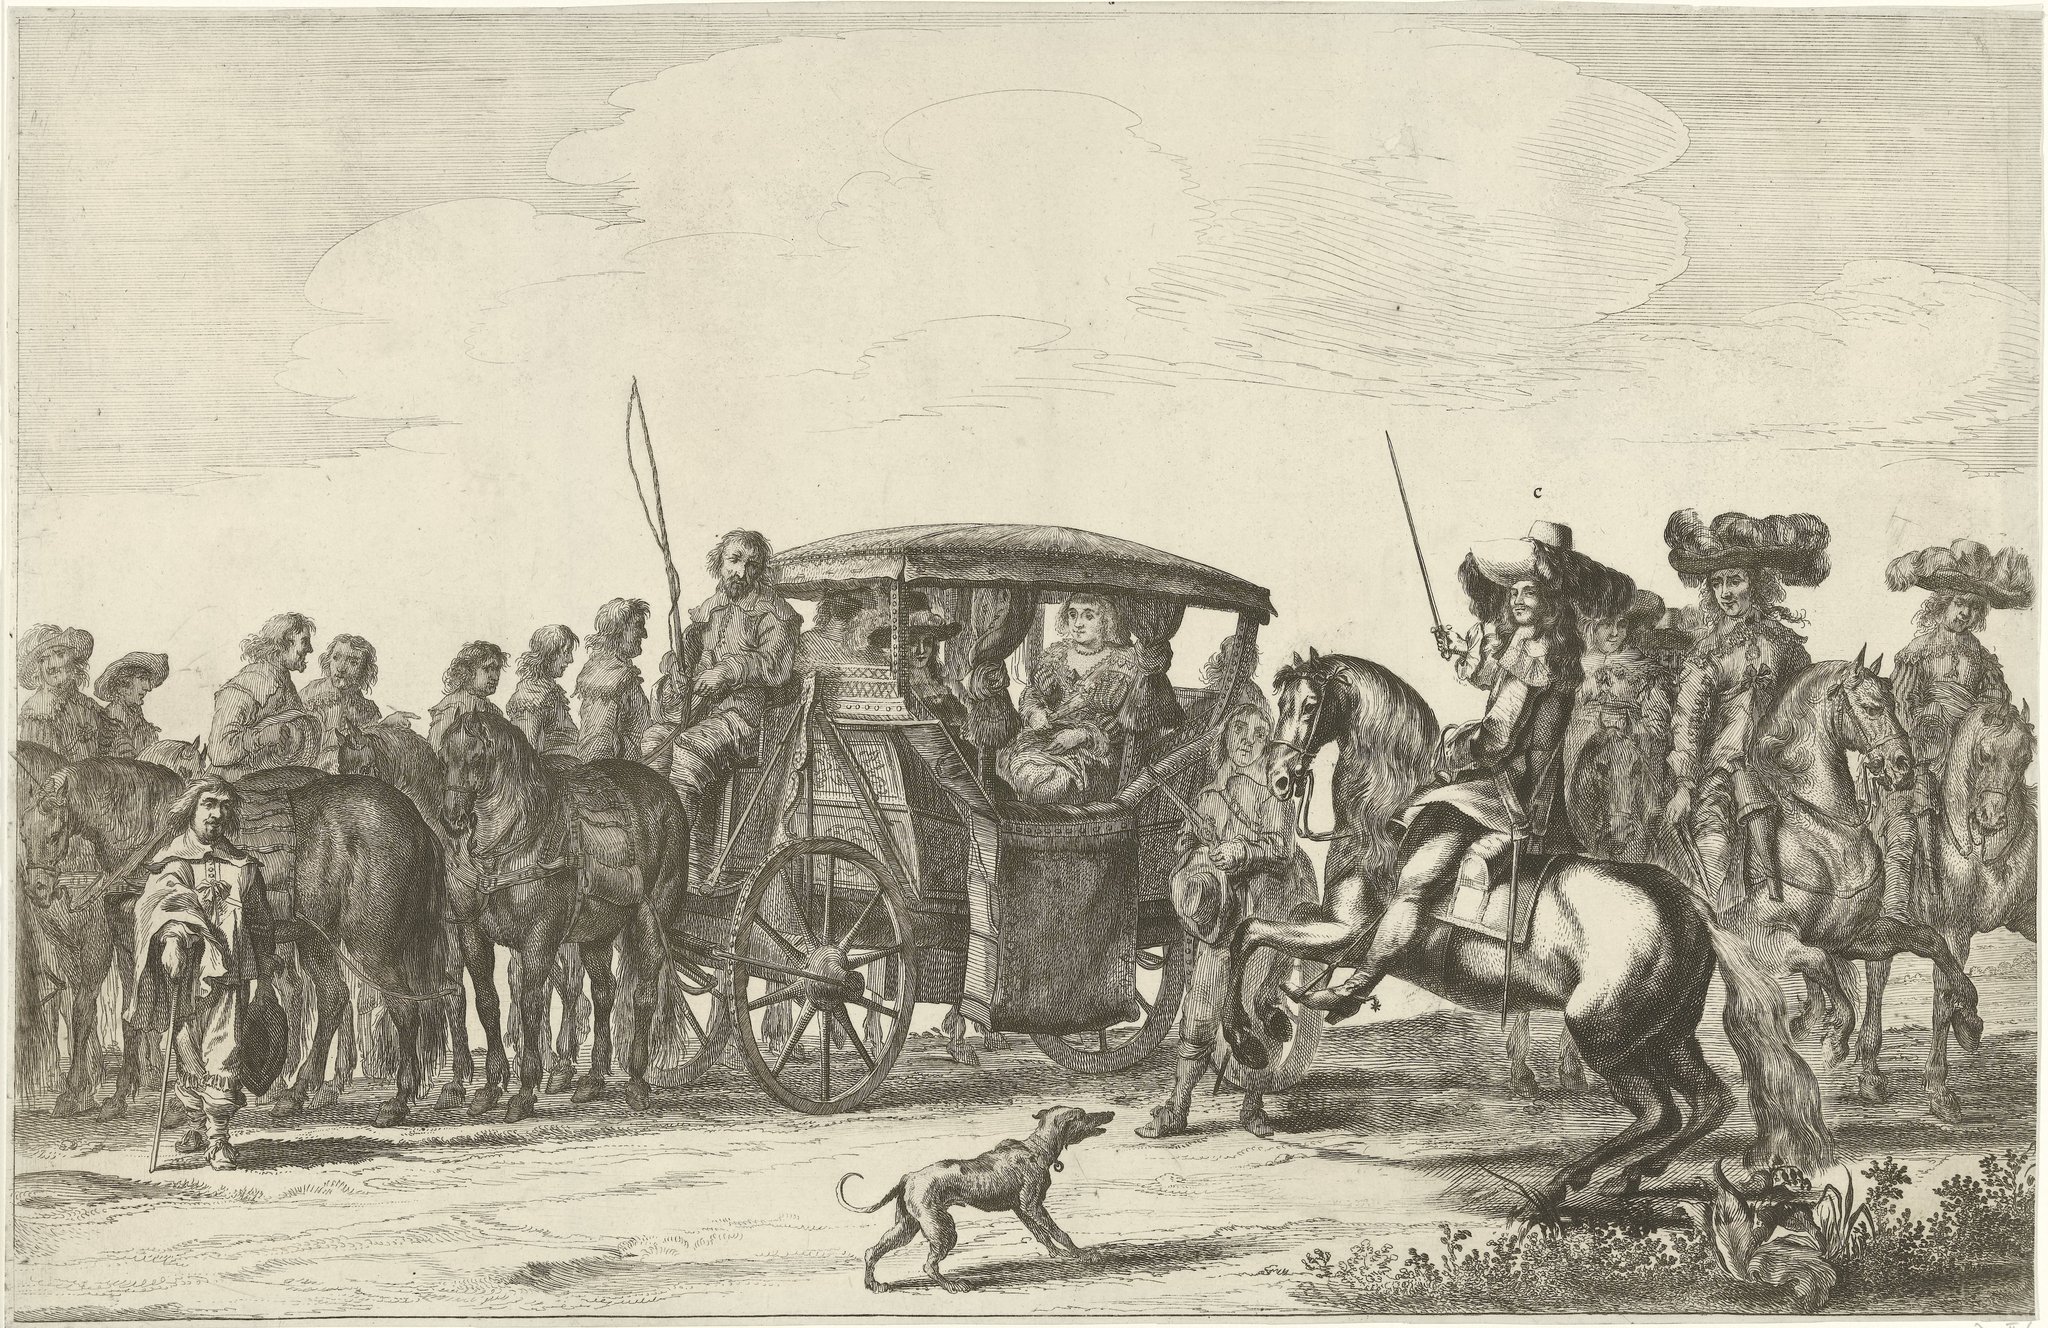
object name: print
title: Intocht van Maria Henrietta Stuart, prinses van Oranje te Amsterdam (plaat 6)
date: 1660-1662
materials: paper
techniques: engraving, etching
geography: northern netherlands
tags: triumphal entry and public reception, pageant, 'entrée solennelle', 'joyeuse entrée'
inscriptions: collector's mark: Lugt 2228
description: Bezoek van Maria Henrietta Stuart, prinses van Oranje, vergezeld door Amalia van Solms, de jonge prins Willem III en anderen te Amsterdam, 15 juni 1660. Blad met het rijtuig met Maria Henrietta Stuart, Amalia van Solms en de prins en een deel van de stoet met ruiters. De ruiter rechts, gemerkt met de letter C, is luitenant Dirck Tulp. Zesde plaat in een ongemonteerd ensemble van de stoet bestaande uit zeven bladen.